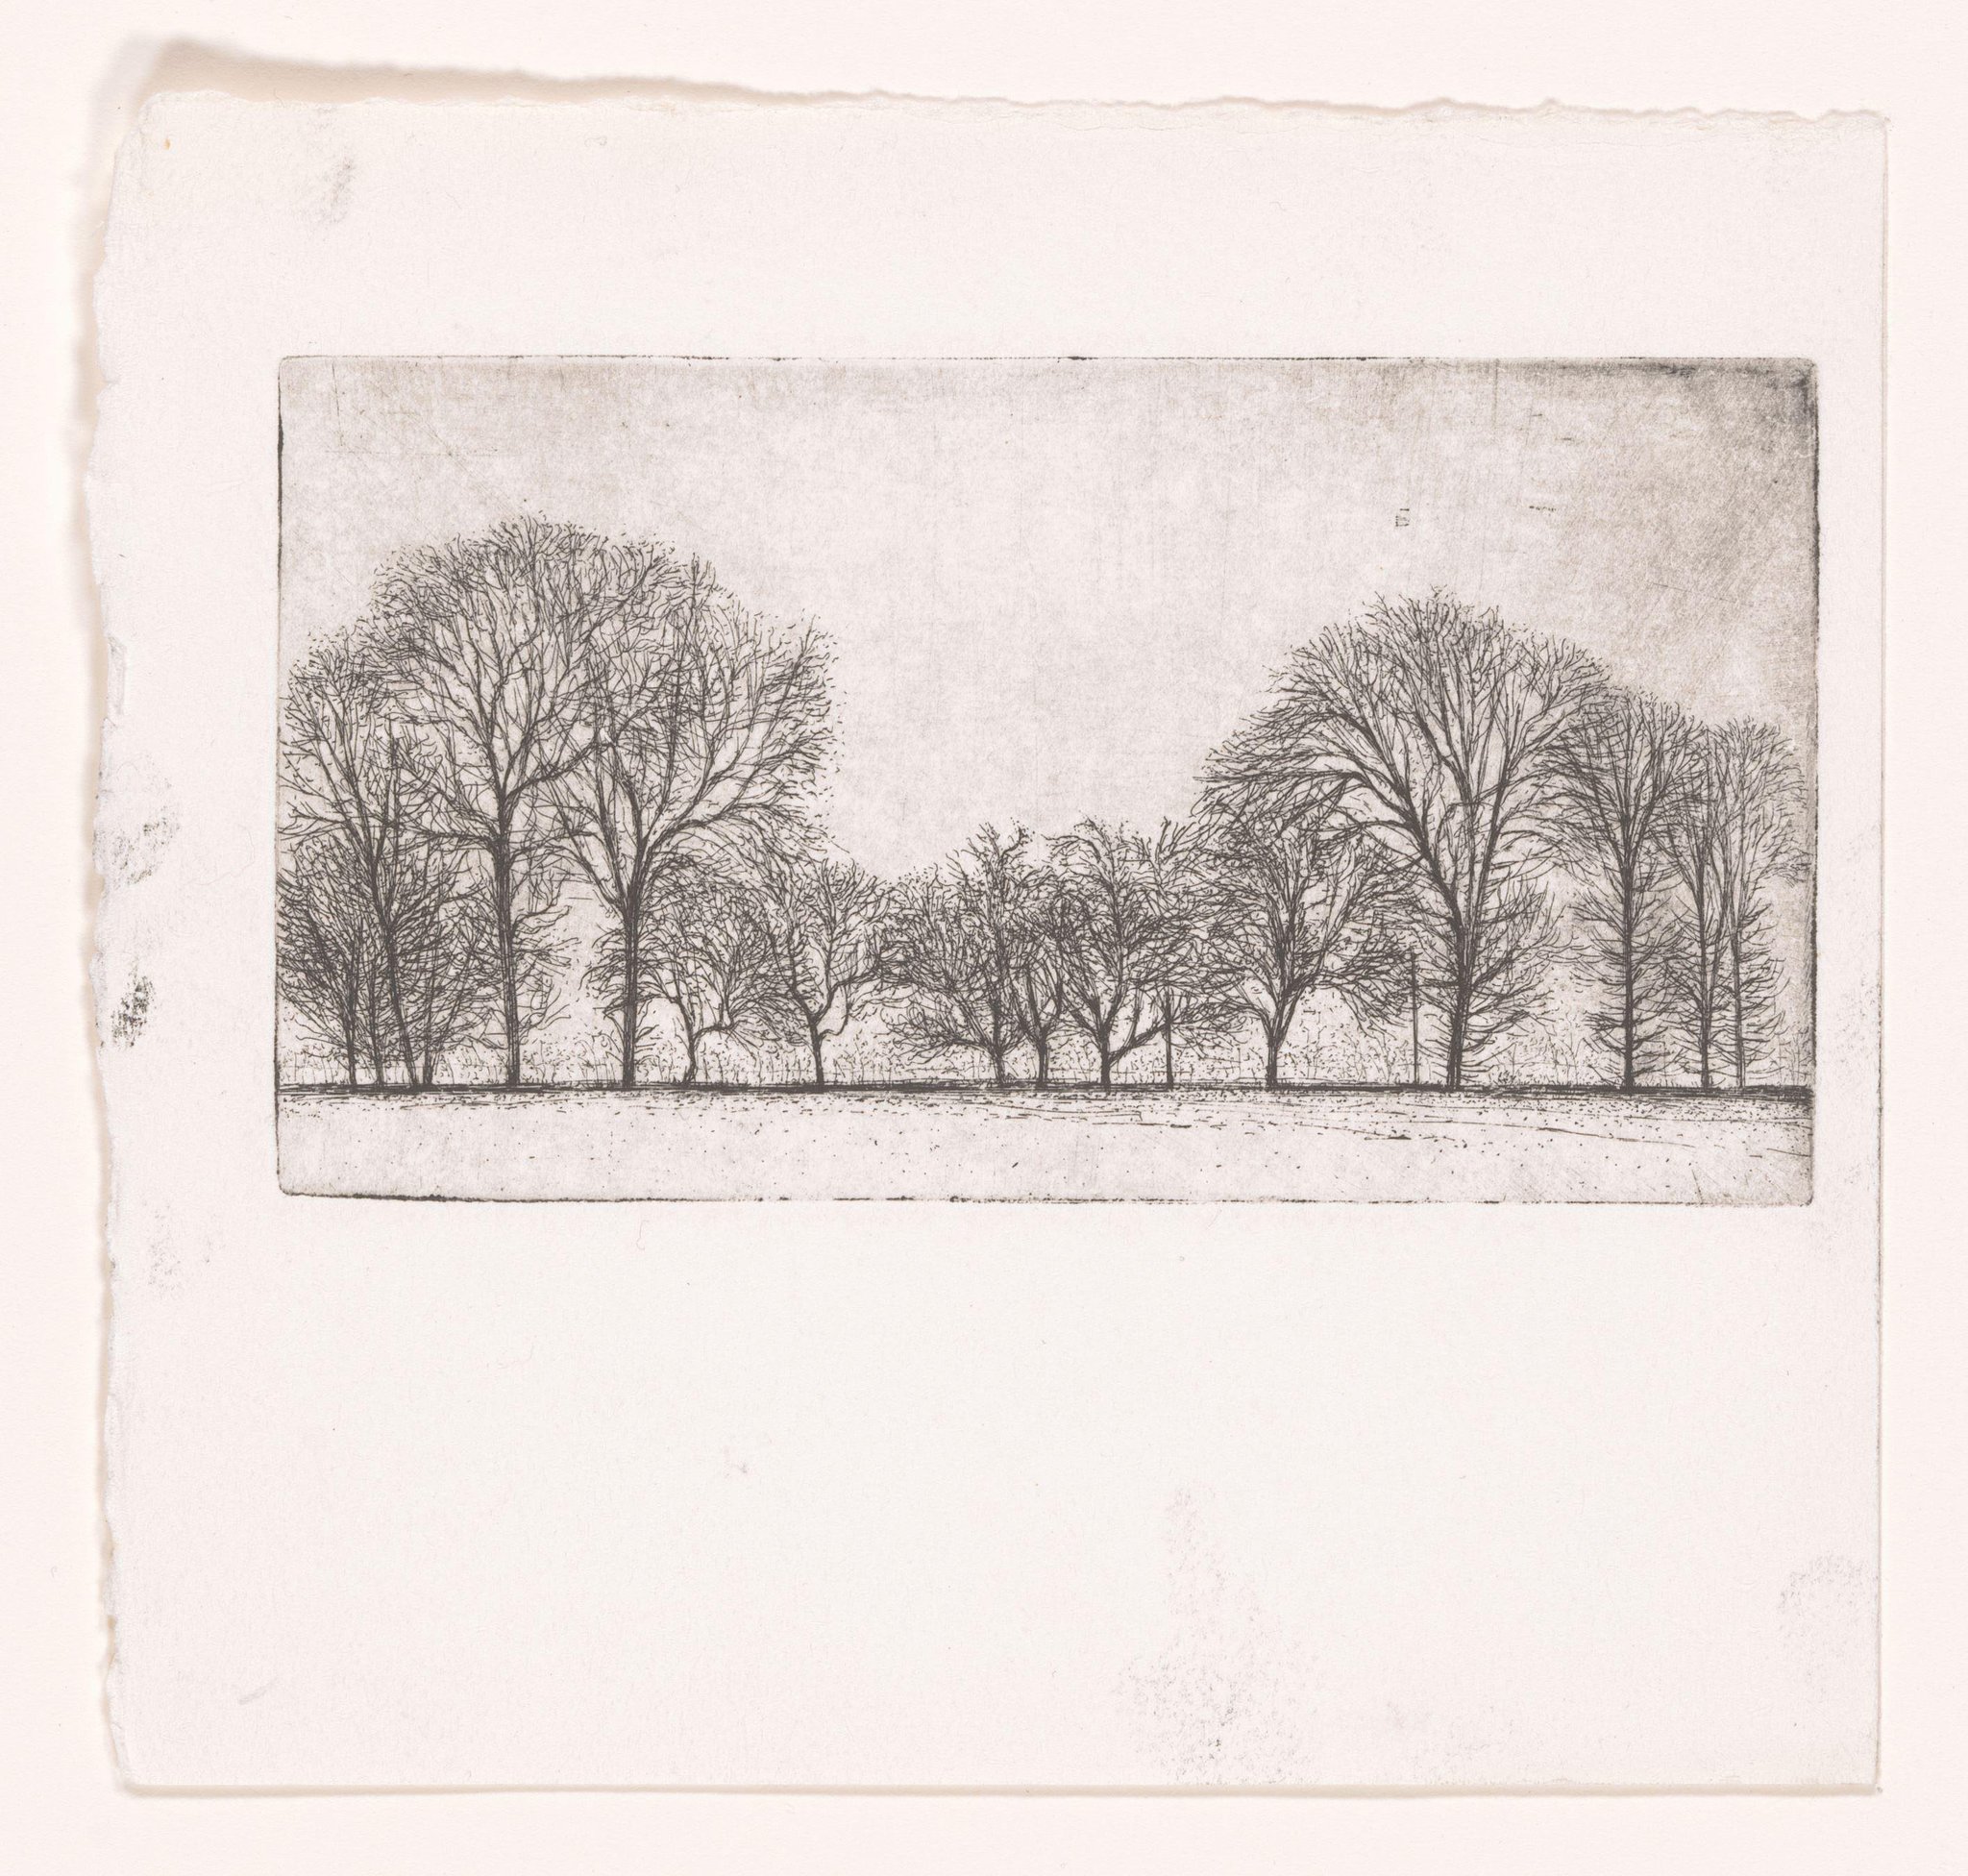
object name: print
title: Kale bomen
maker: kees stoop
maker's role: draughtsman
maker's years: 1929-2019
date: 1944-1990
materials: paper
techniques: etching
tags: trees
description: Kale bomen van verschillende lengtes aan lage horizon.